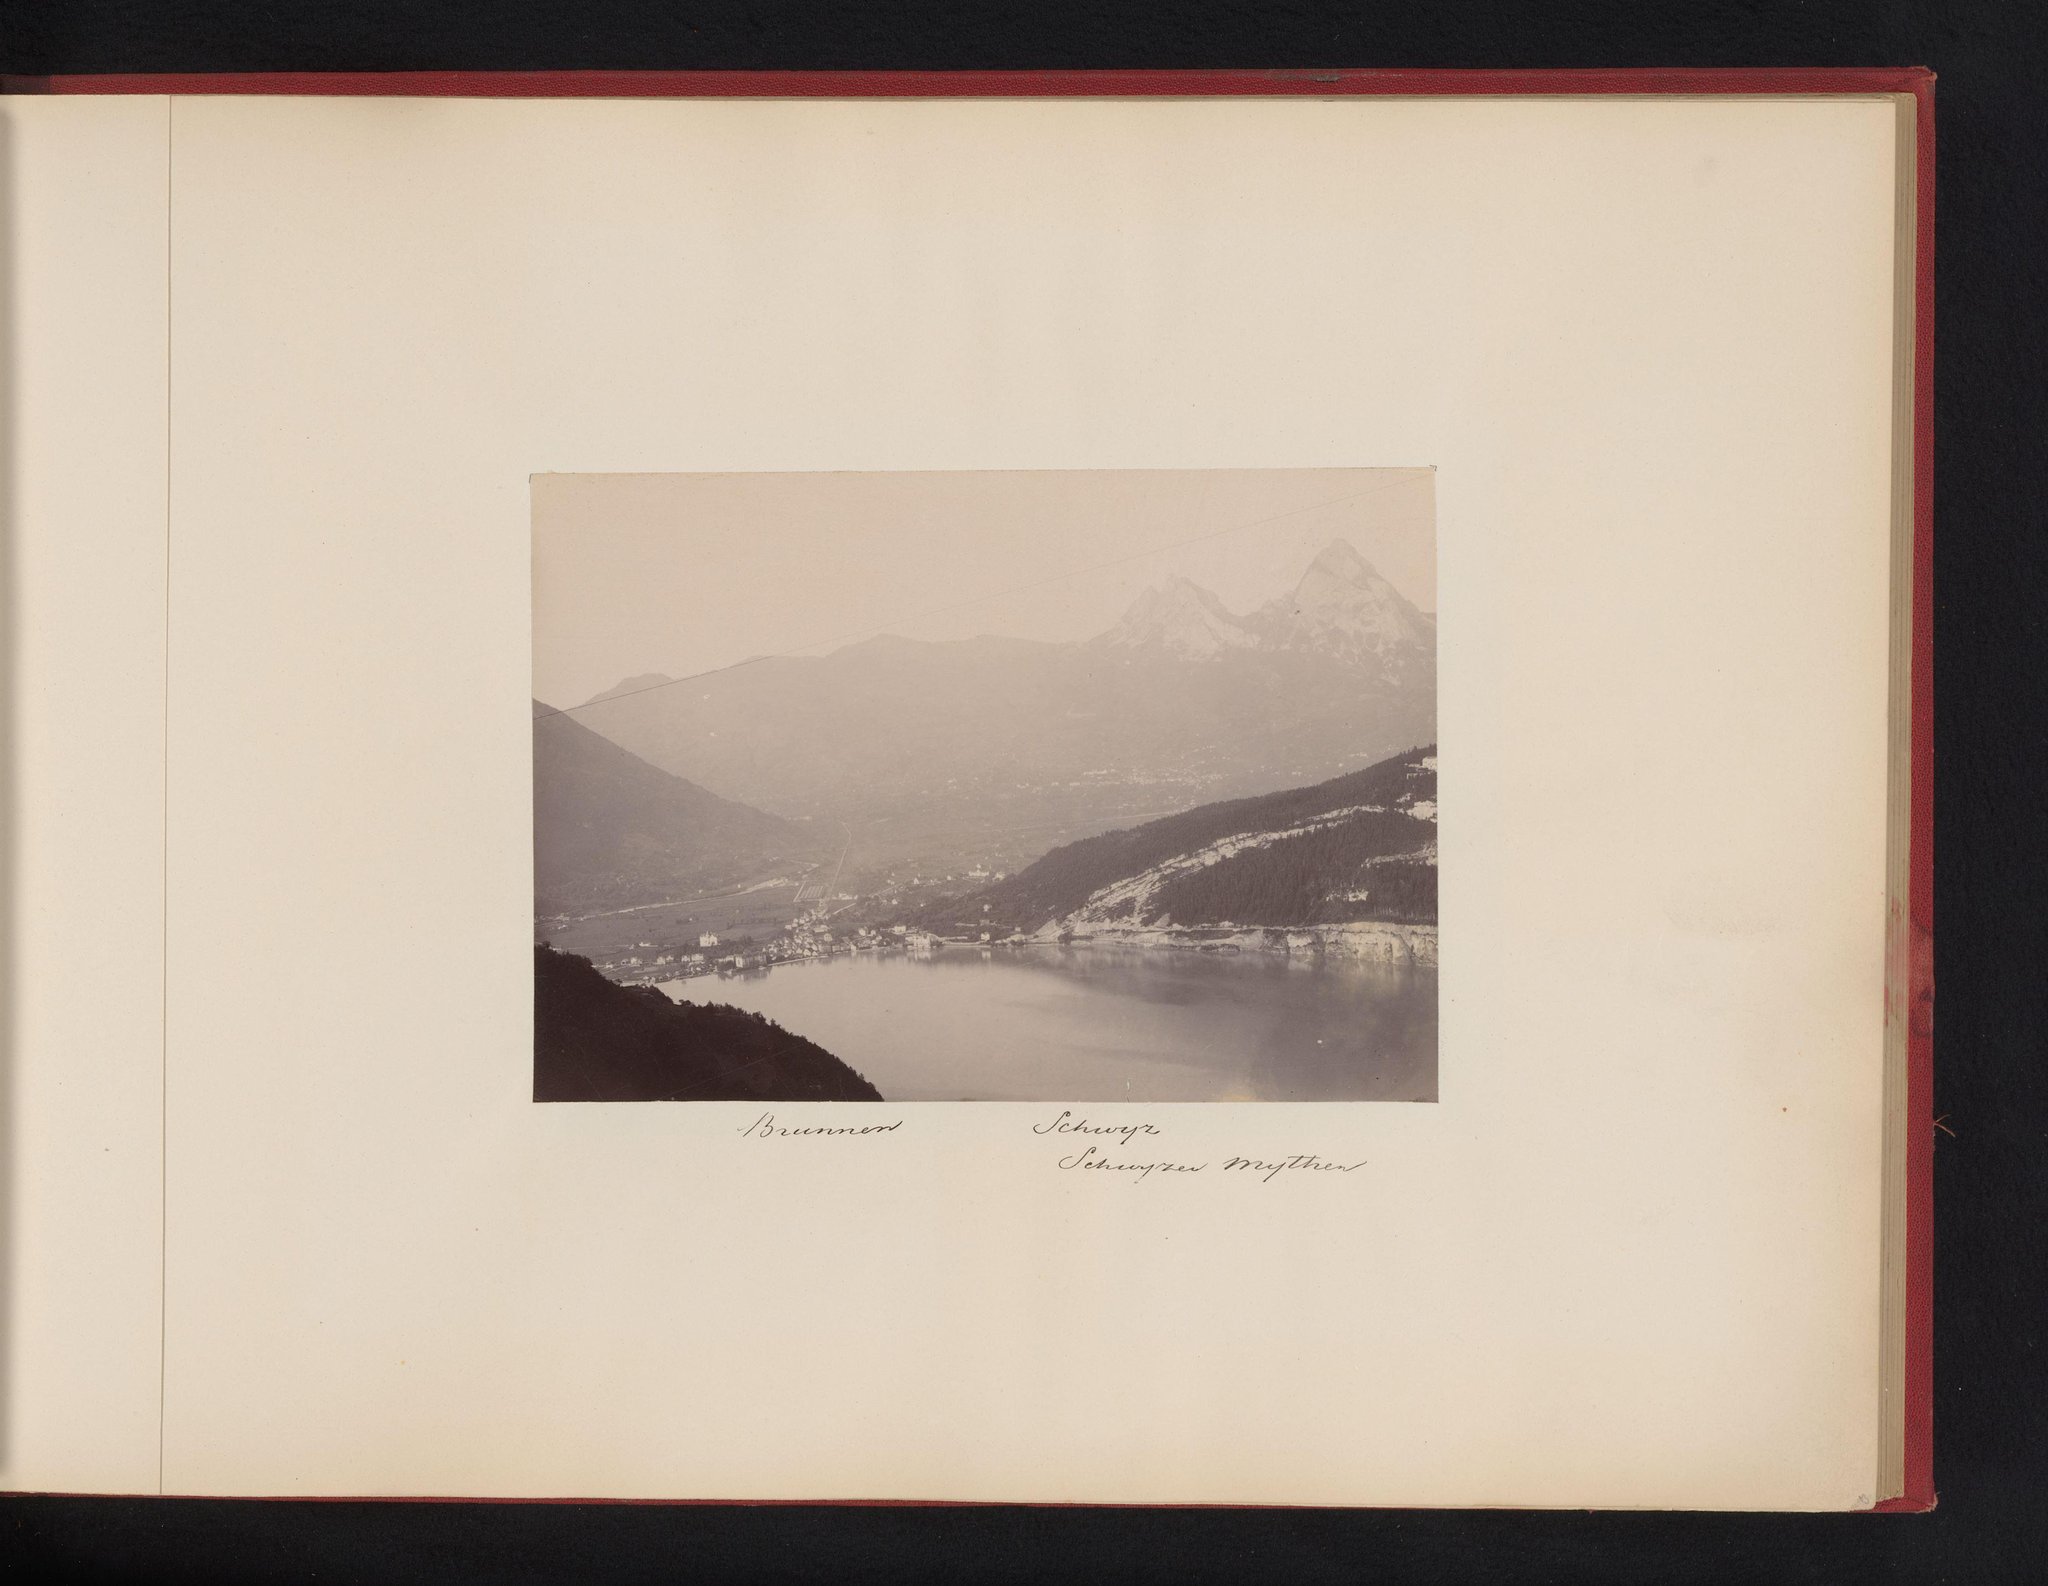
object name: album leaf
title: Gezicht op Brunnen te Zwitserland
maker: Anonymous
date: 1860-1900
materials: photographic support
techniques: albumen print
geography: seelisberg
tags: city-view in general; 'veduta', lake, mountains